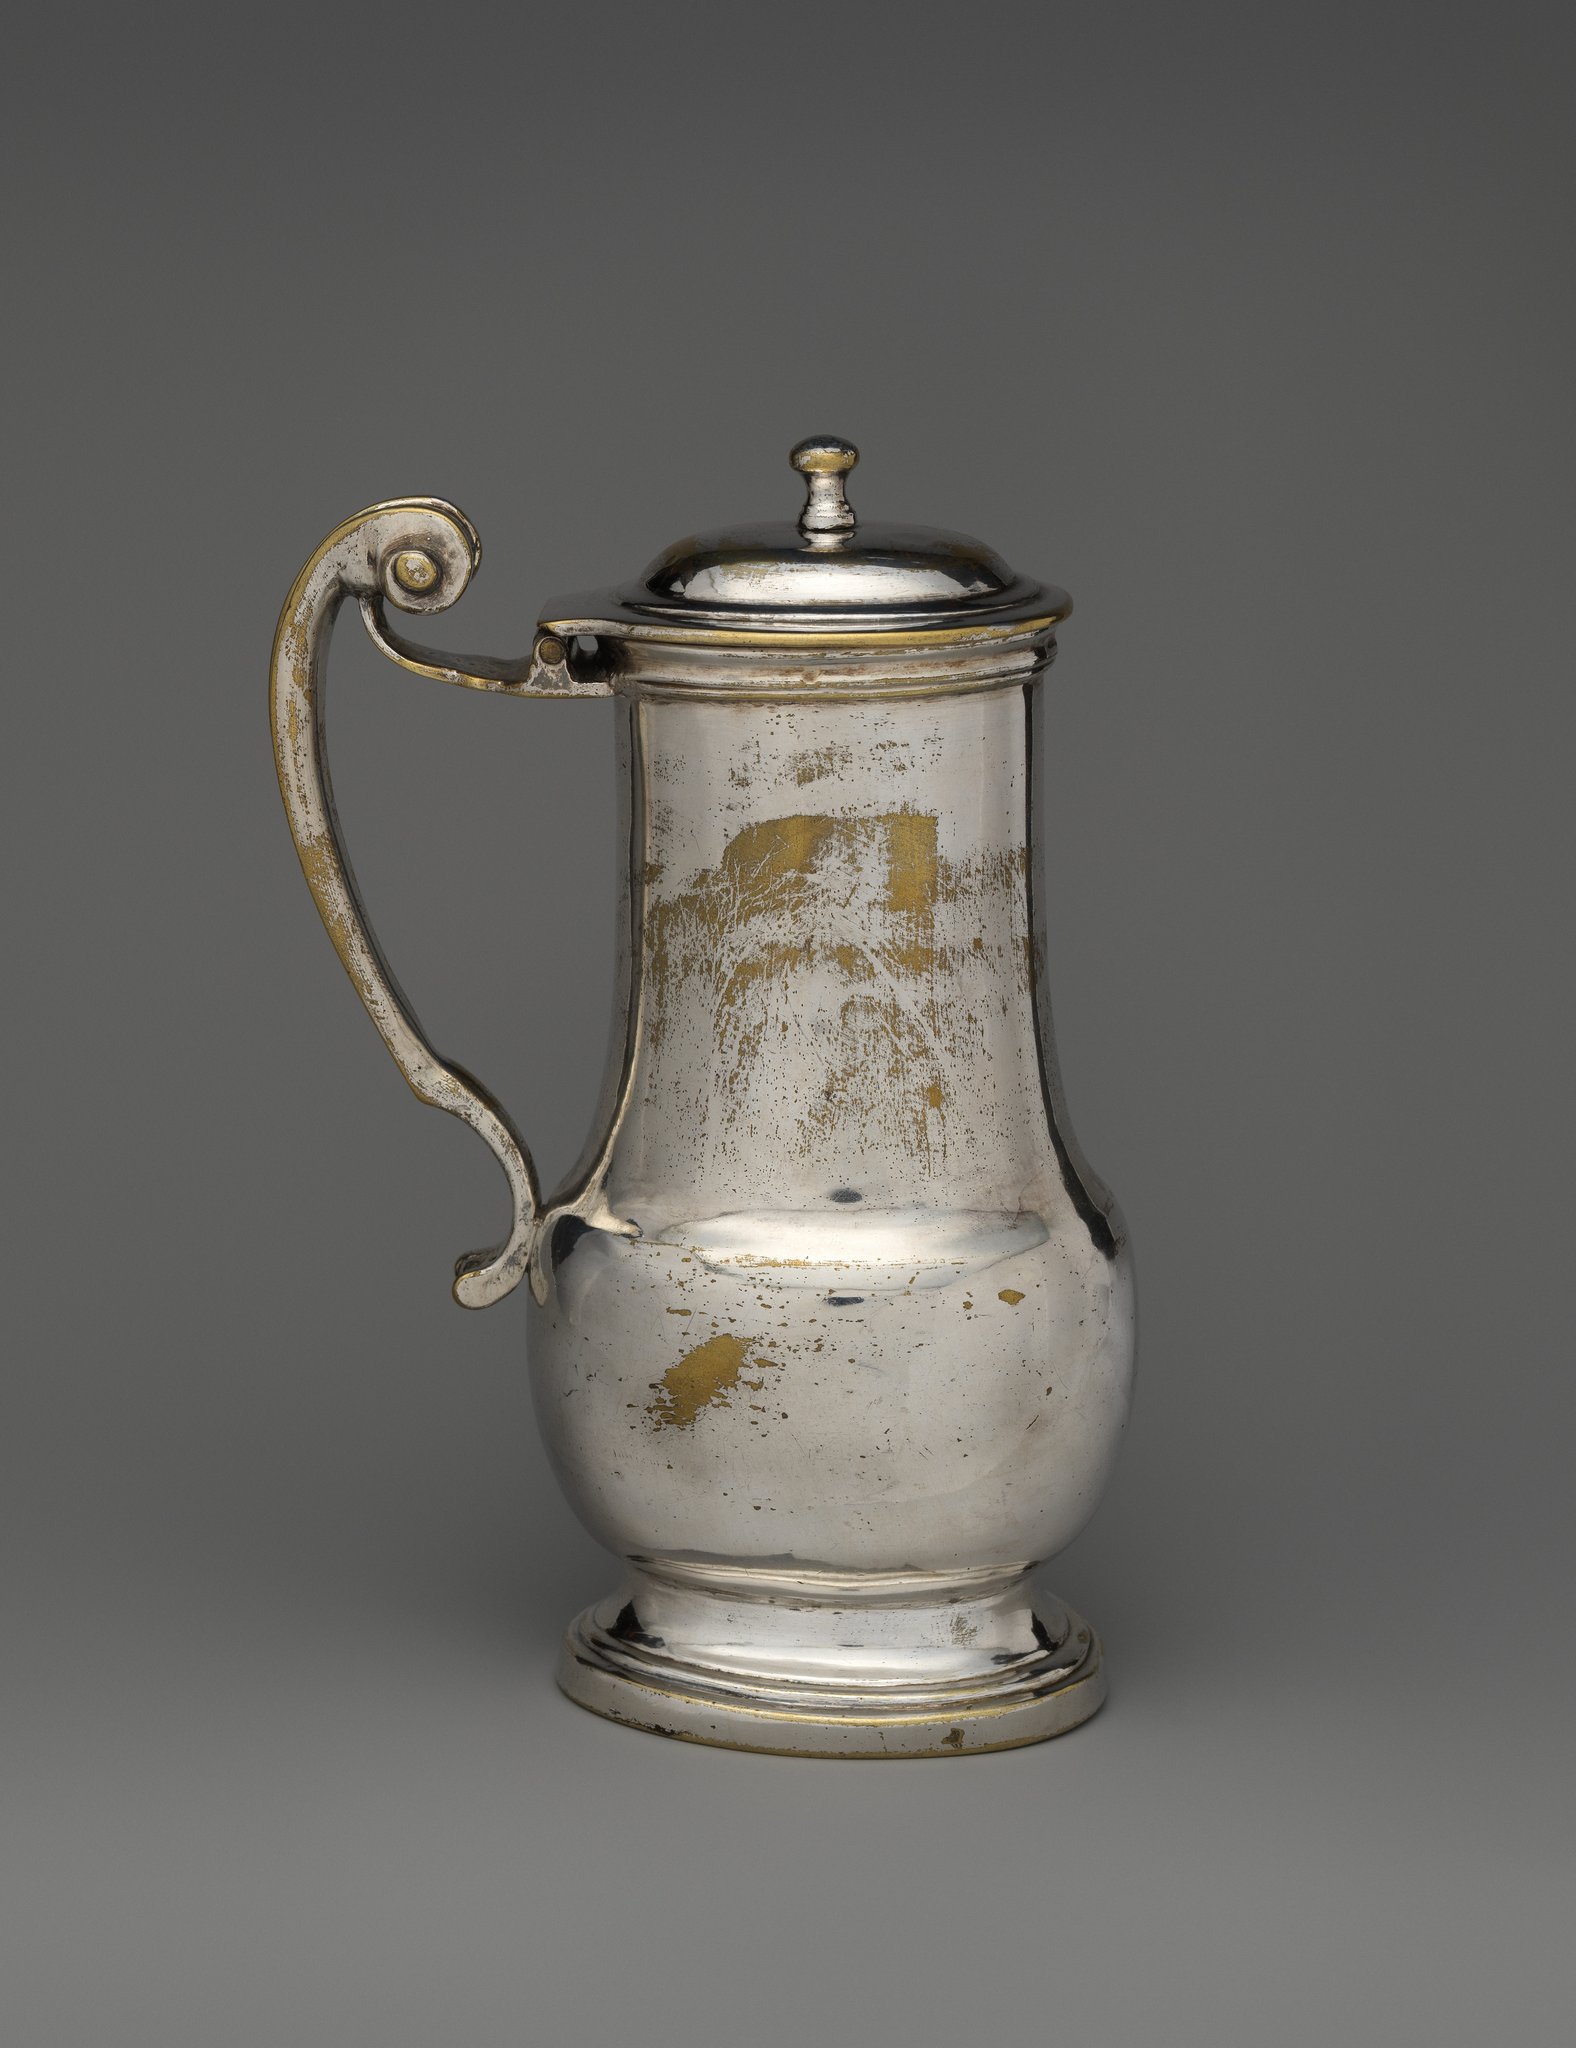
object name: shaving jug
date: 1730-1740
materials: brass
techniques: silvered